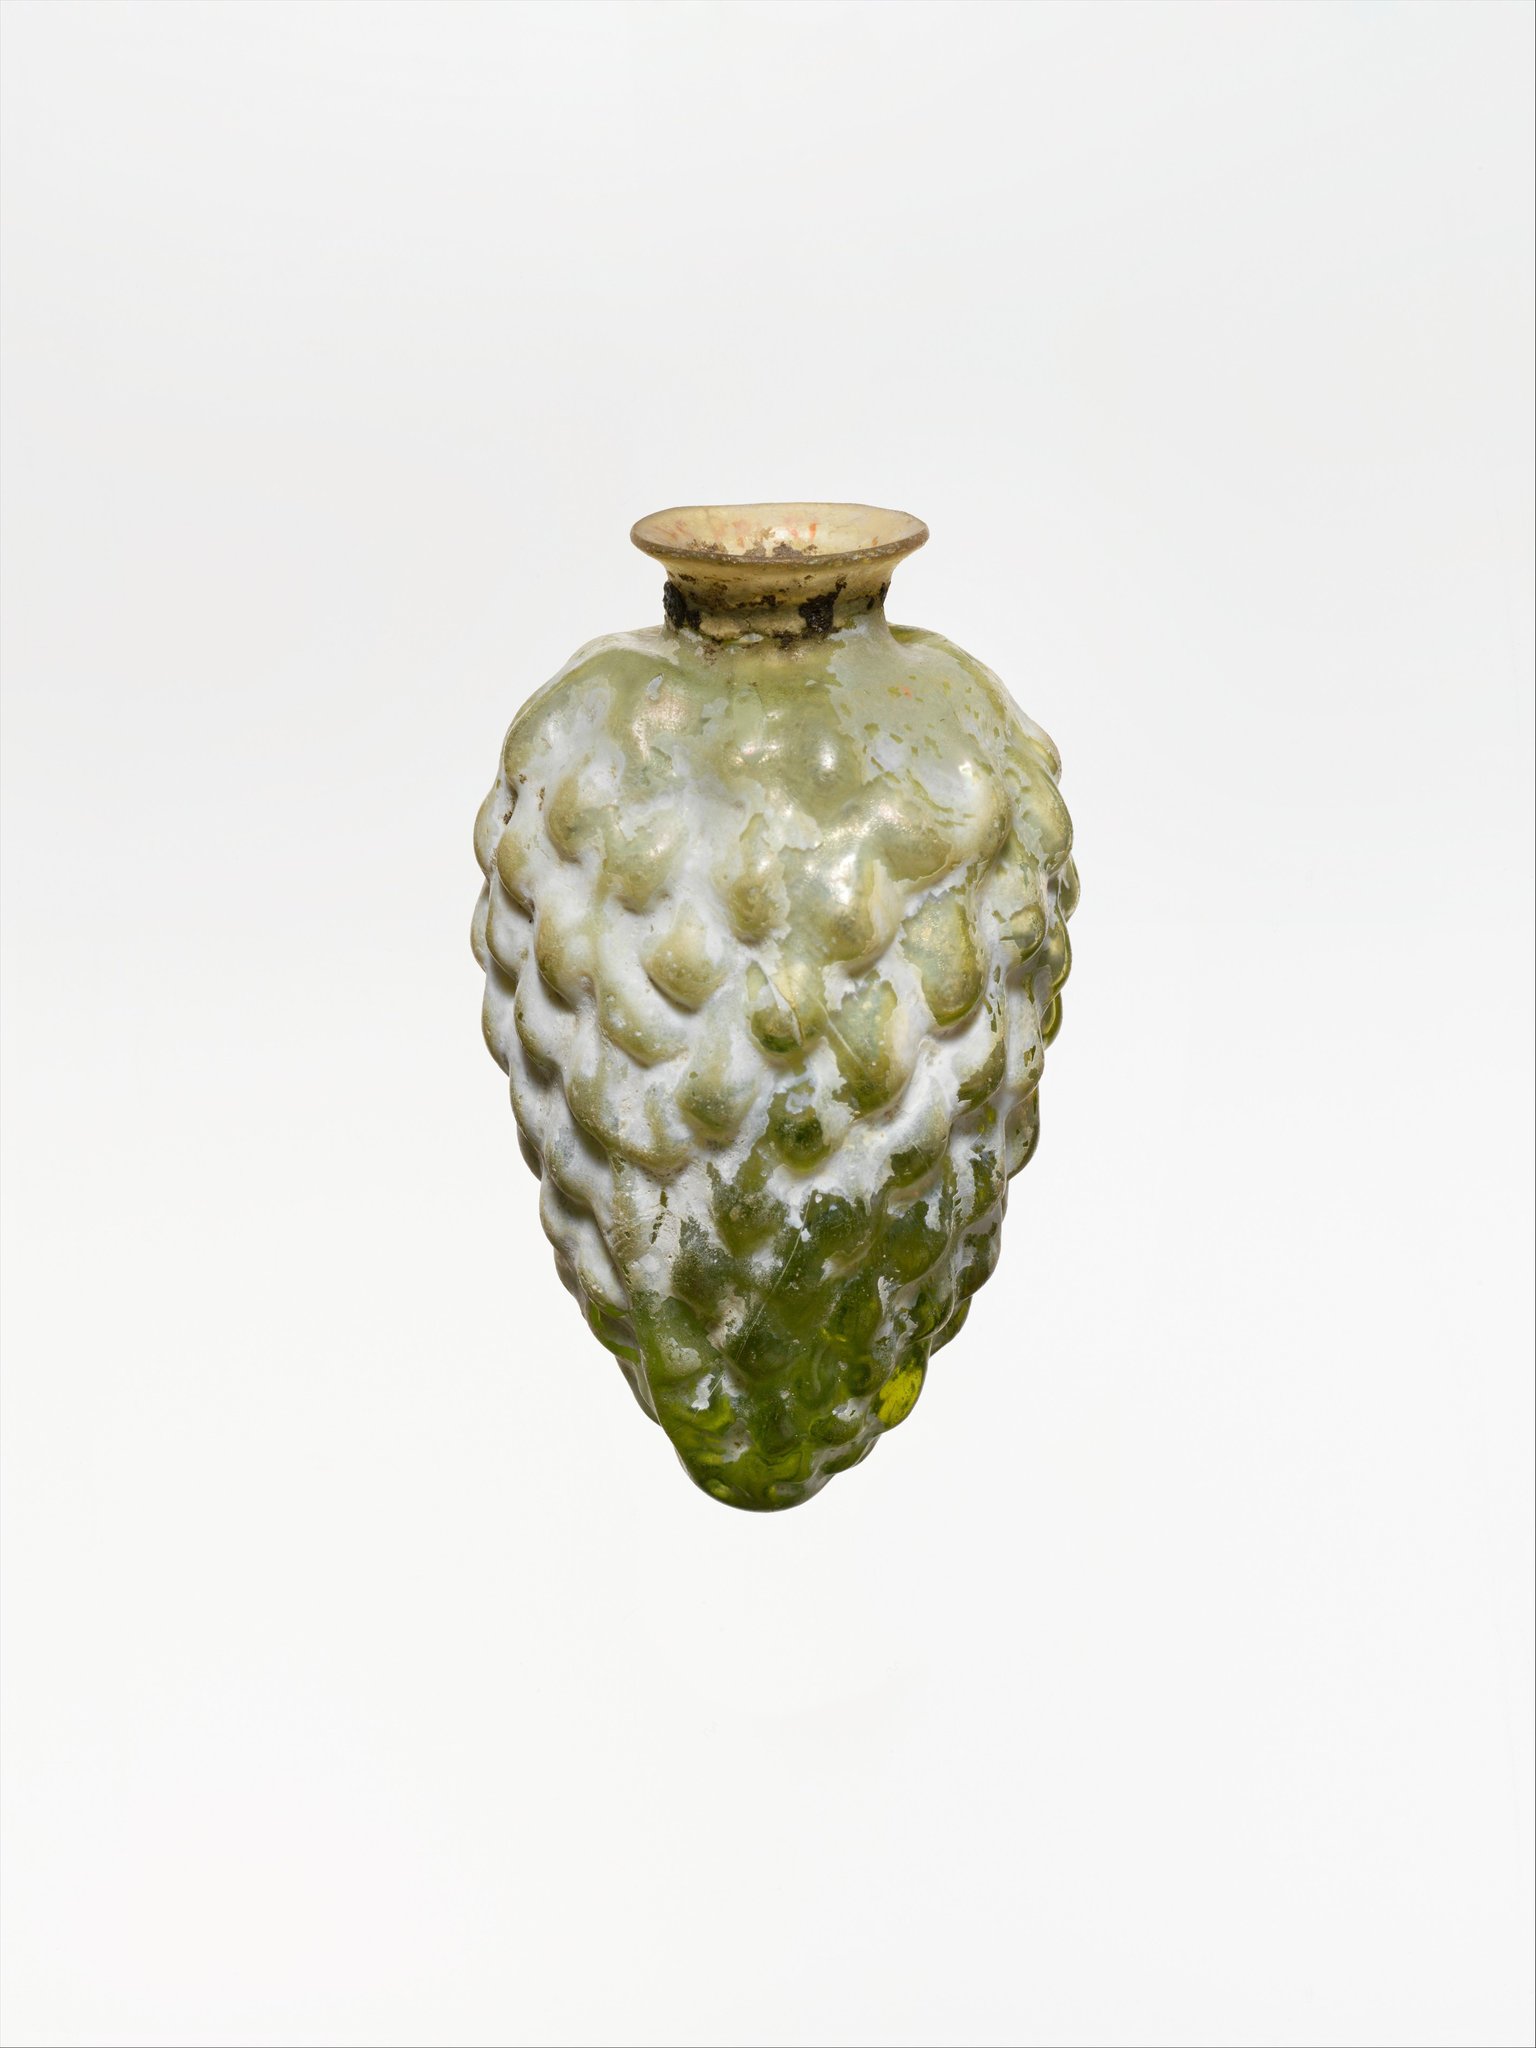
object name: flask in the form of a pine cone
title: Glass flask in the shape of a pine cone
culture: roman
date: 51-100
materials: glass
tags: pinecones